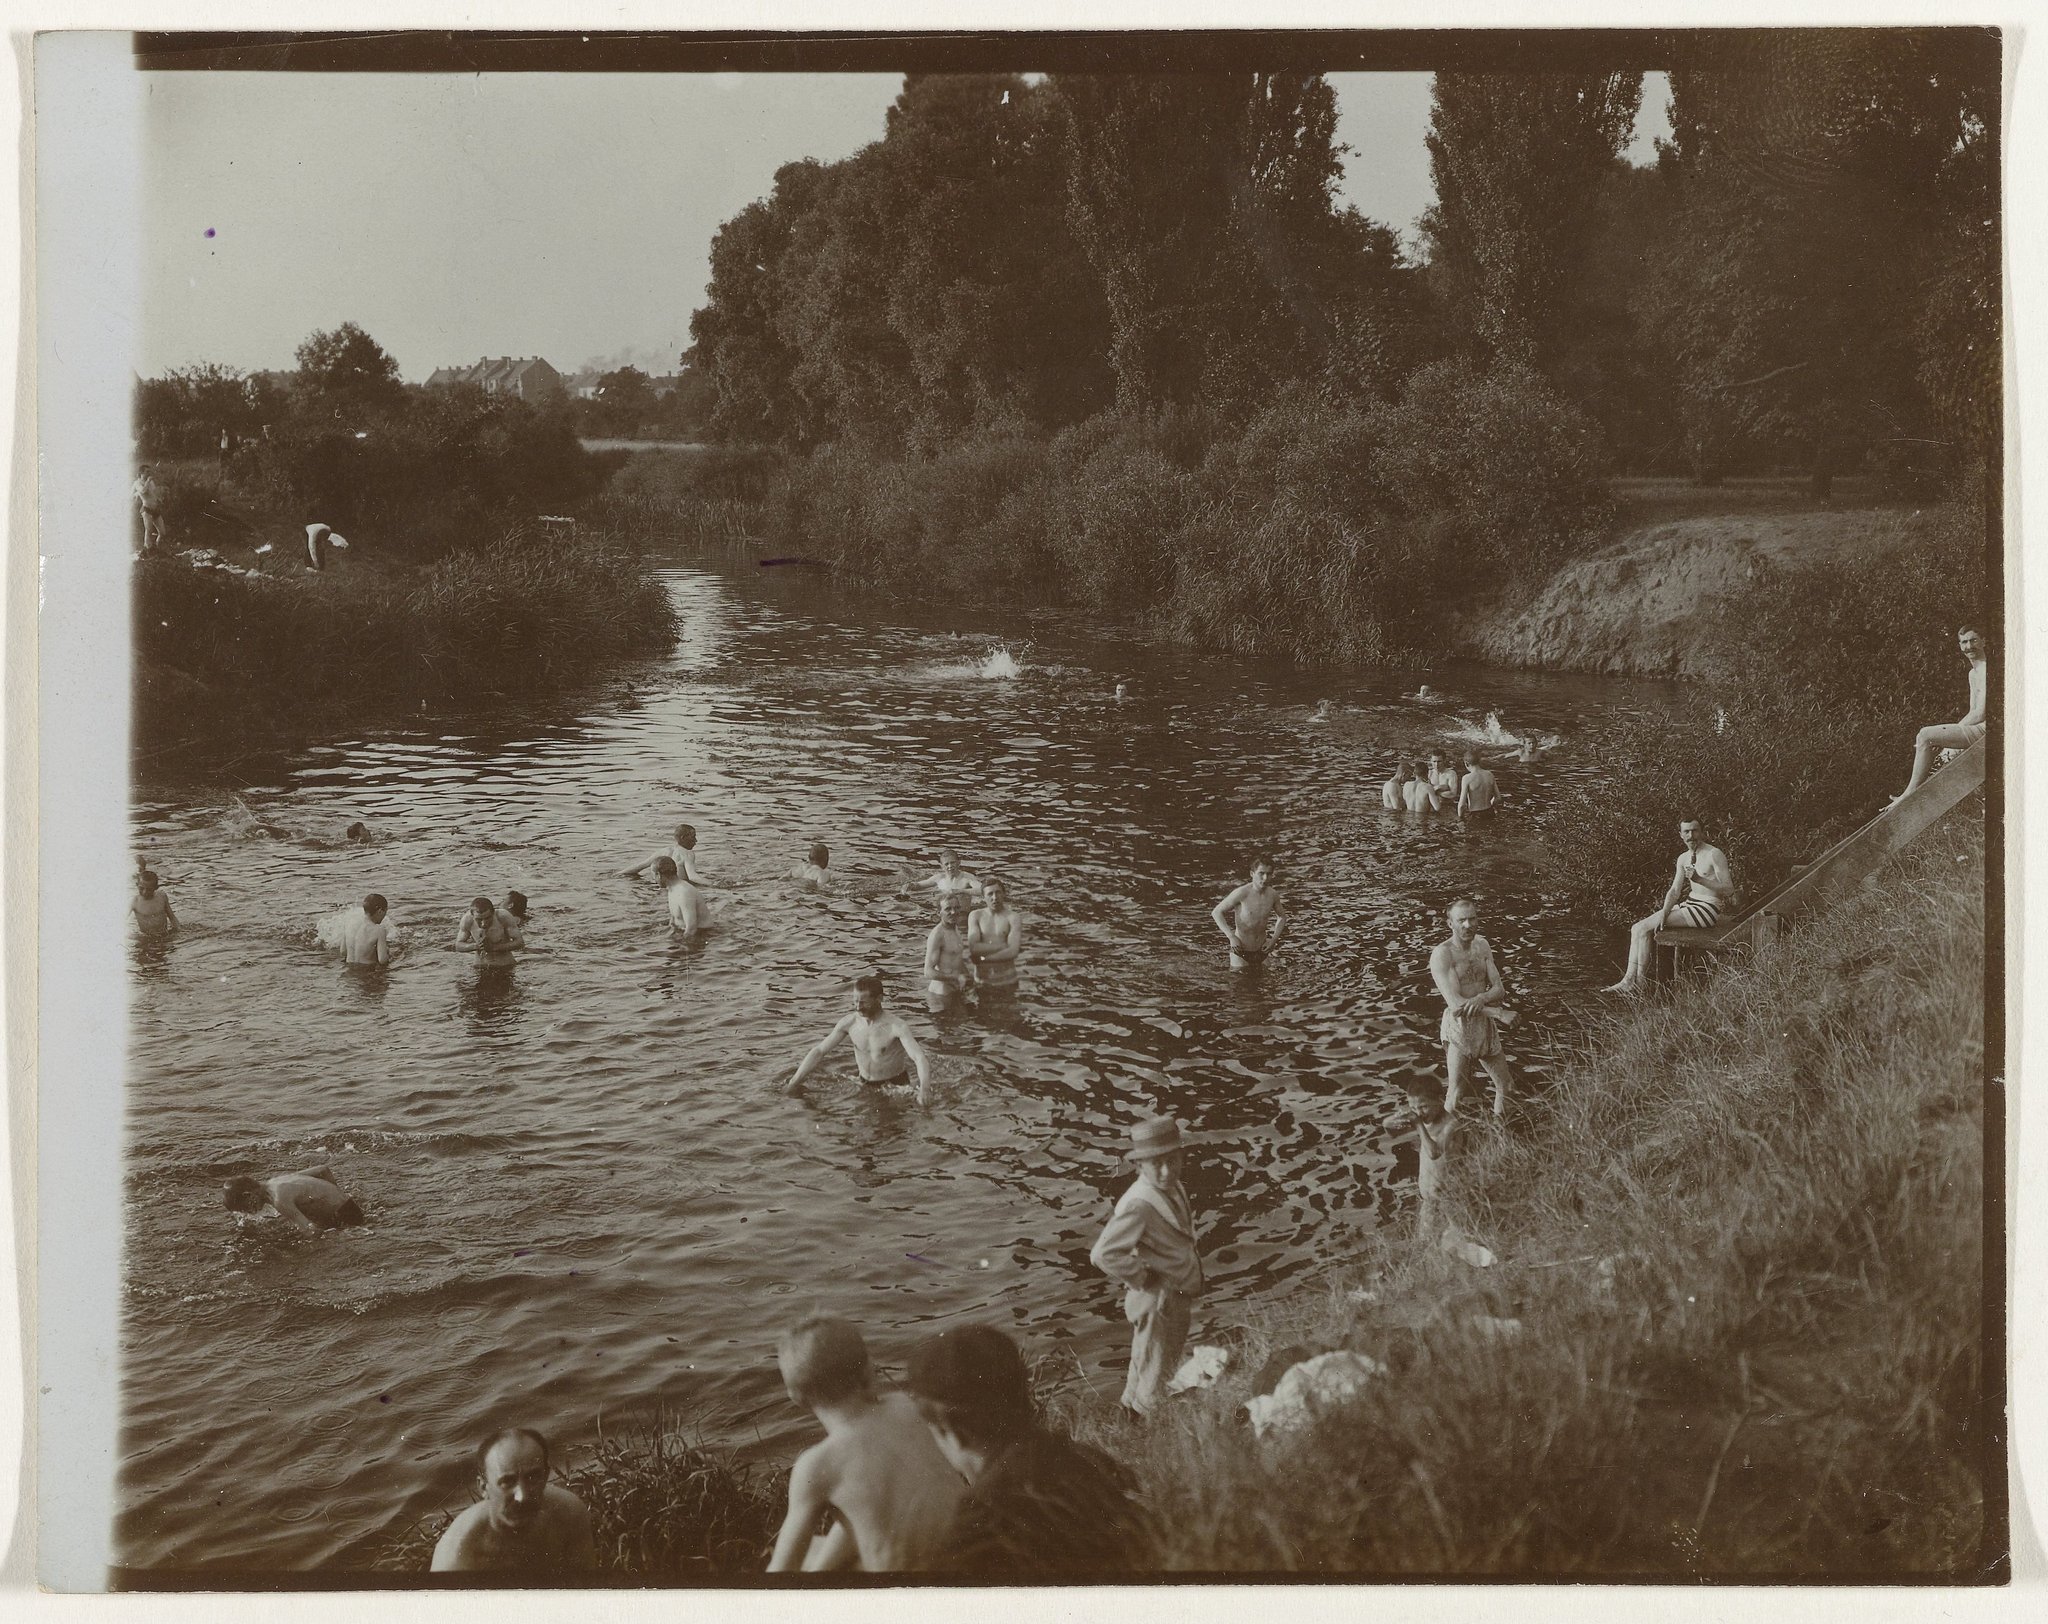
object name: photograph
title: Zwemmende mensen in een rivier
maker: Anonymous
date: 1900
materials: paper, photographic support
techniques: collodion silver print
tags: swimming (sport), river (+ landscape with figures, staffage)